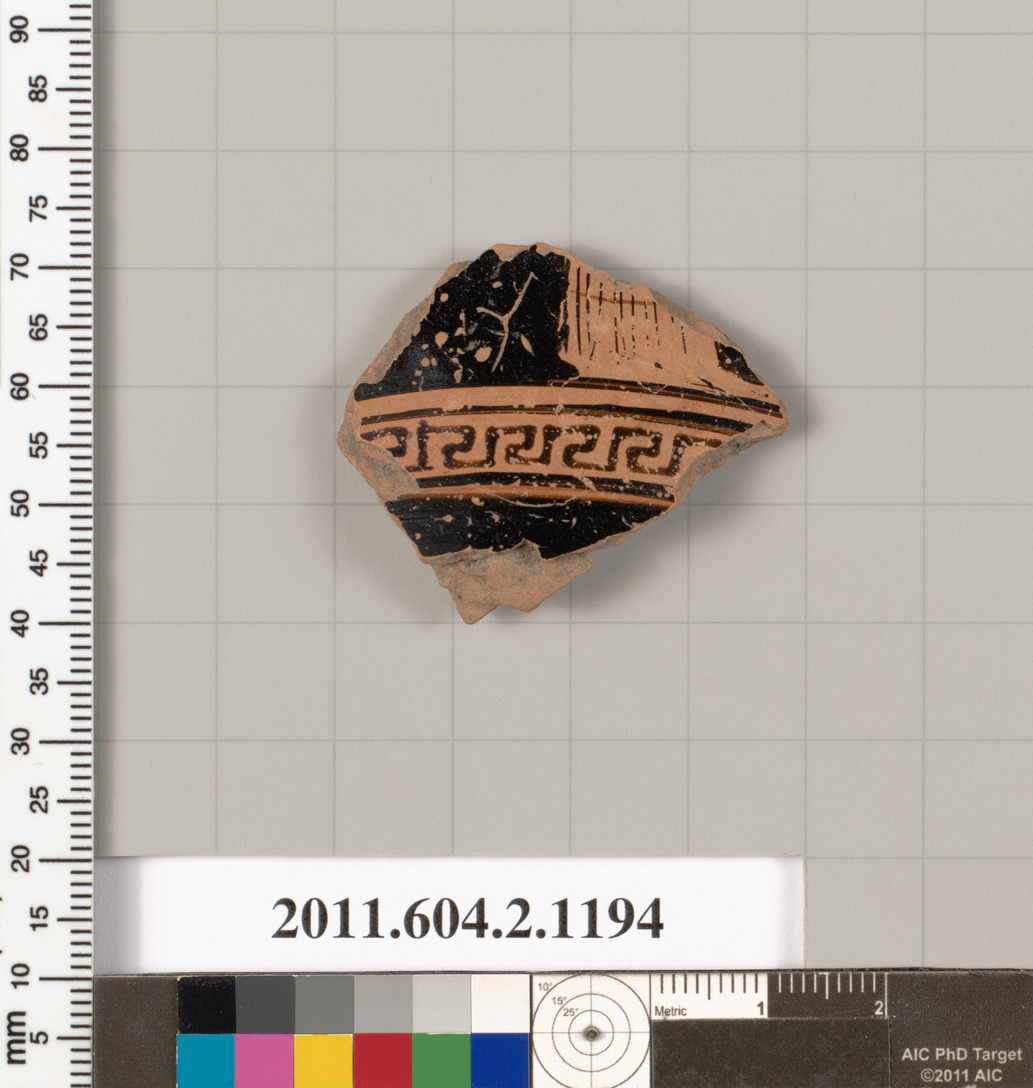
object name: lekythos fragment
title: Terracotta fragment of a squat lekythos (oil flask)?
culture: greek, attic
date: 450-401 BCE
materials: terracotta